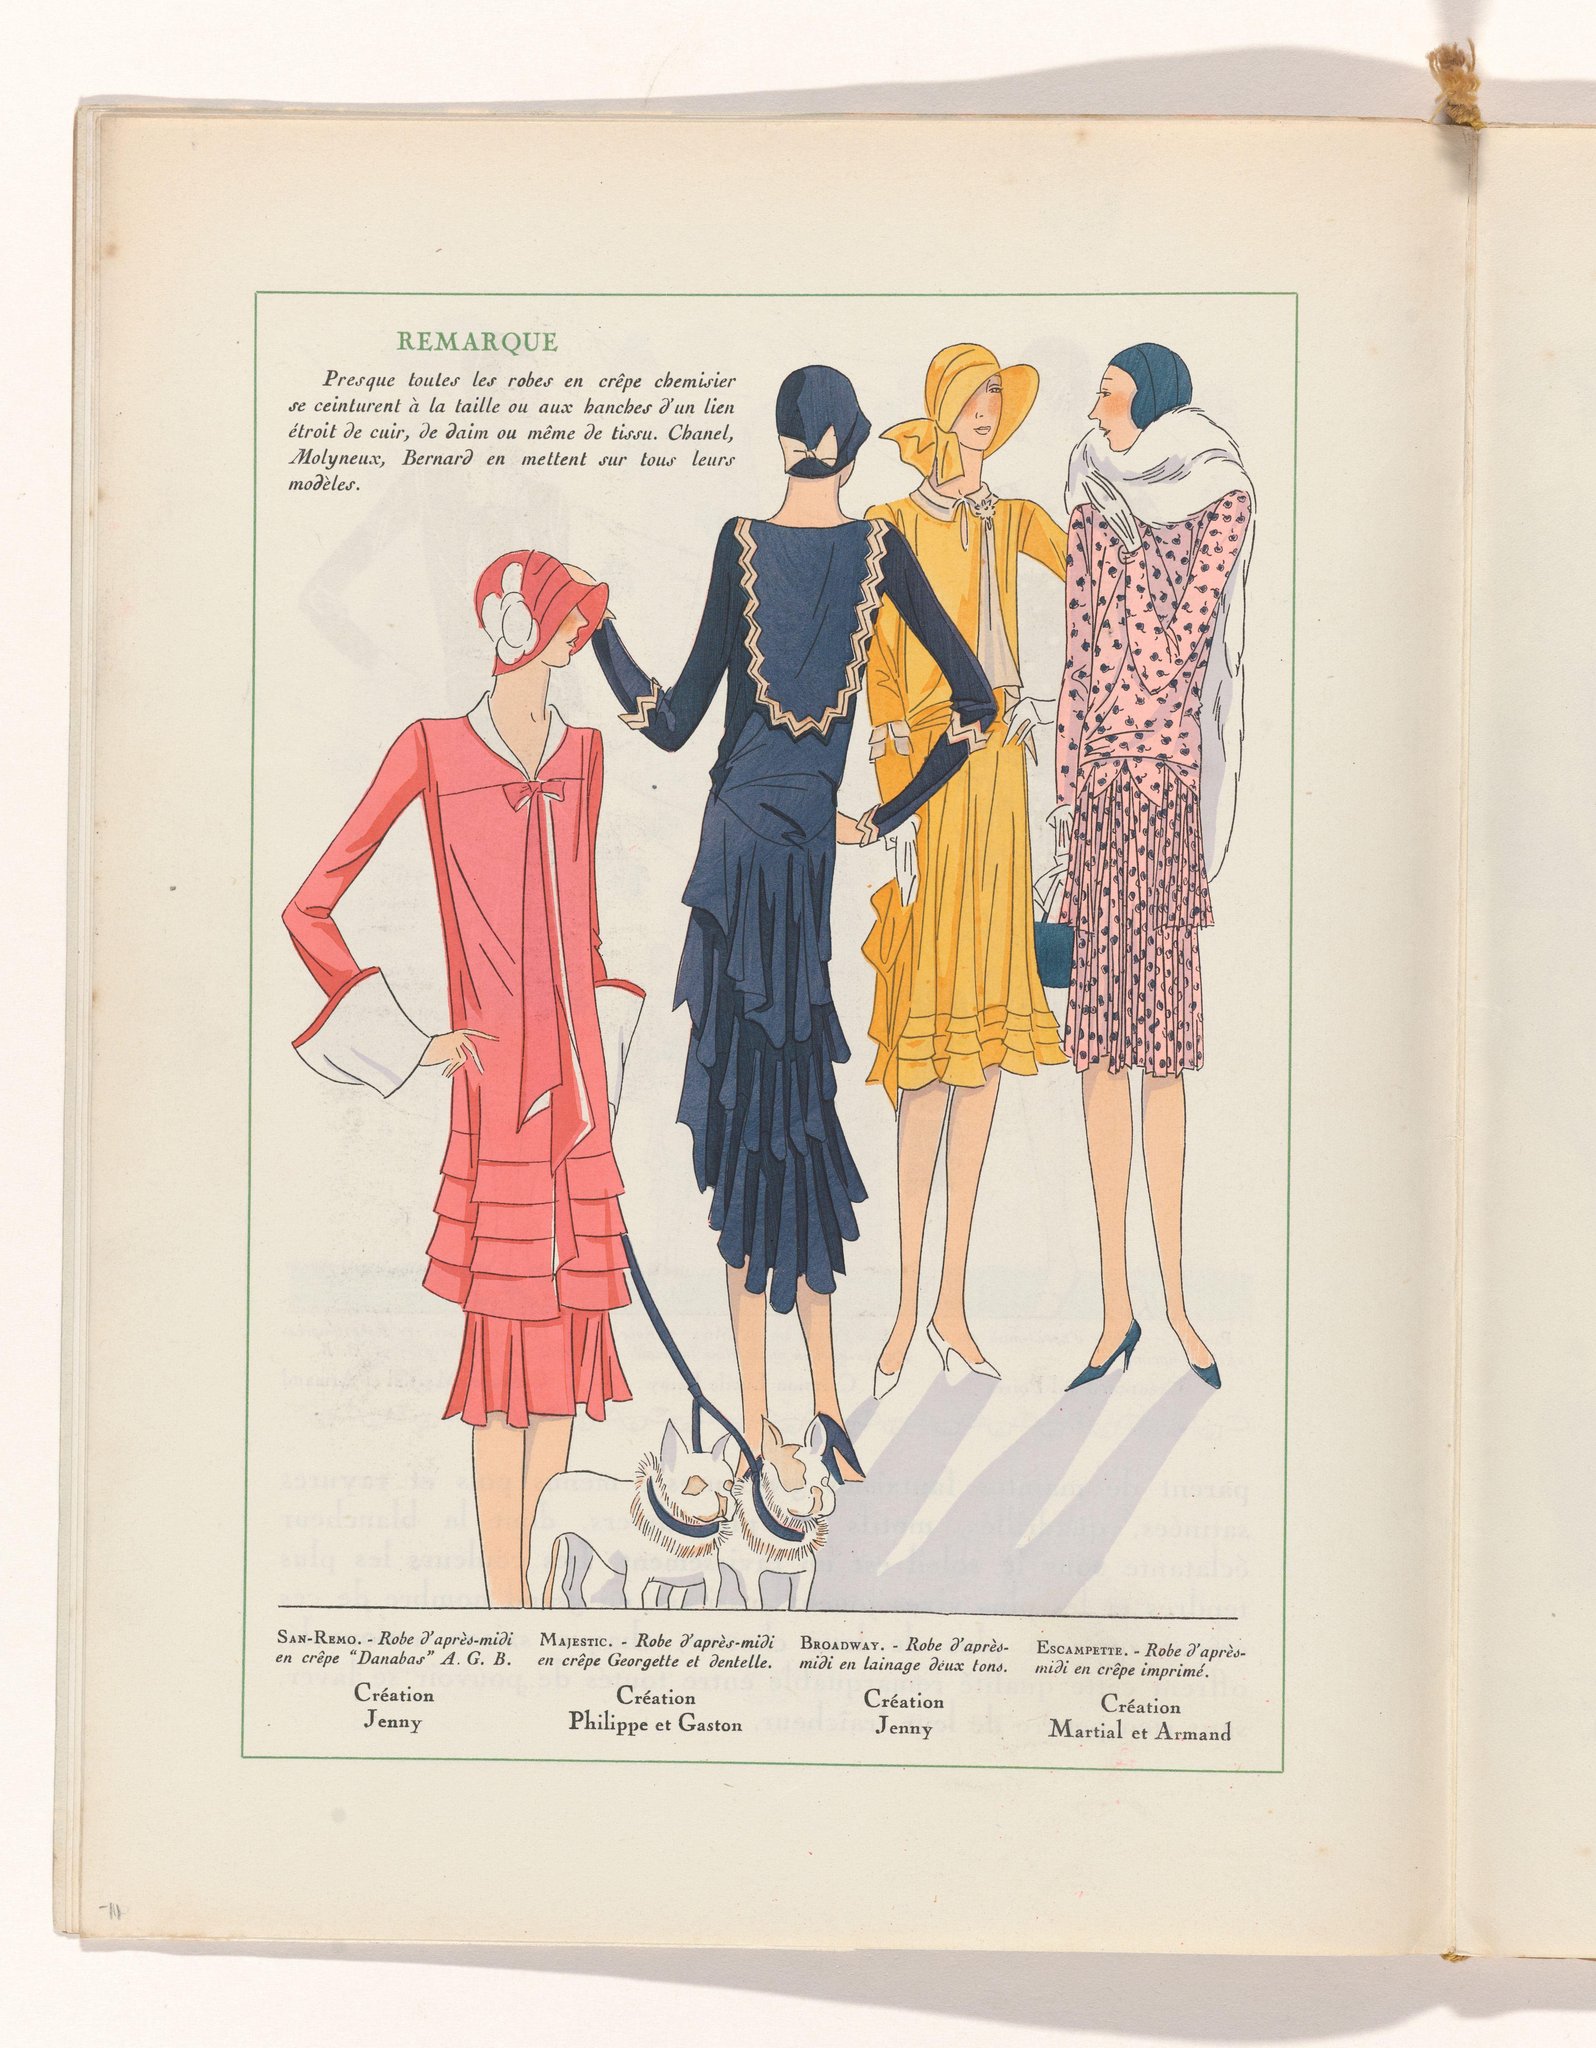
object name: fashion print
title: Art - Goût - Beauté, Feuillets de l' élégance féminine, Juin 1929, No. 106, 9e Année, p.11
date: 1929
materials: paper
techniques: hand coloring, lithograph, pochoir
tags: bag (handbag) (+ women's clothes), lace (+ women's clothes), gloves, mittens (short gloves) (+ women's clothes), dress, gown: day dress (+ women's clothes), fashion plates, clothing for the upper part of the body (shawl) (+ fur used for clothes), walking the dog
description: Verschillende middagjaponnen. Van links naar rechts: roze middagjapon van crêpe "Danabas" A.G.B., van Jenny. Blauwe middagjapon van crêpe Georgette en kant, van Philippe et Gaston. Gele middagjapon van tweekleurige wol, van Jenny. Roze middagjapon van bedrukte crêpe, van Martial et Armand. Pagina uit het modetijdschrift Art-Goût-Beauté (1920-1933).